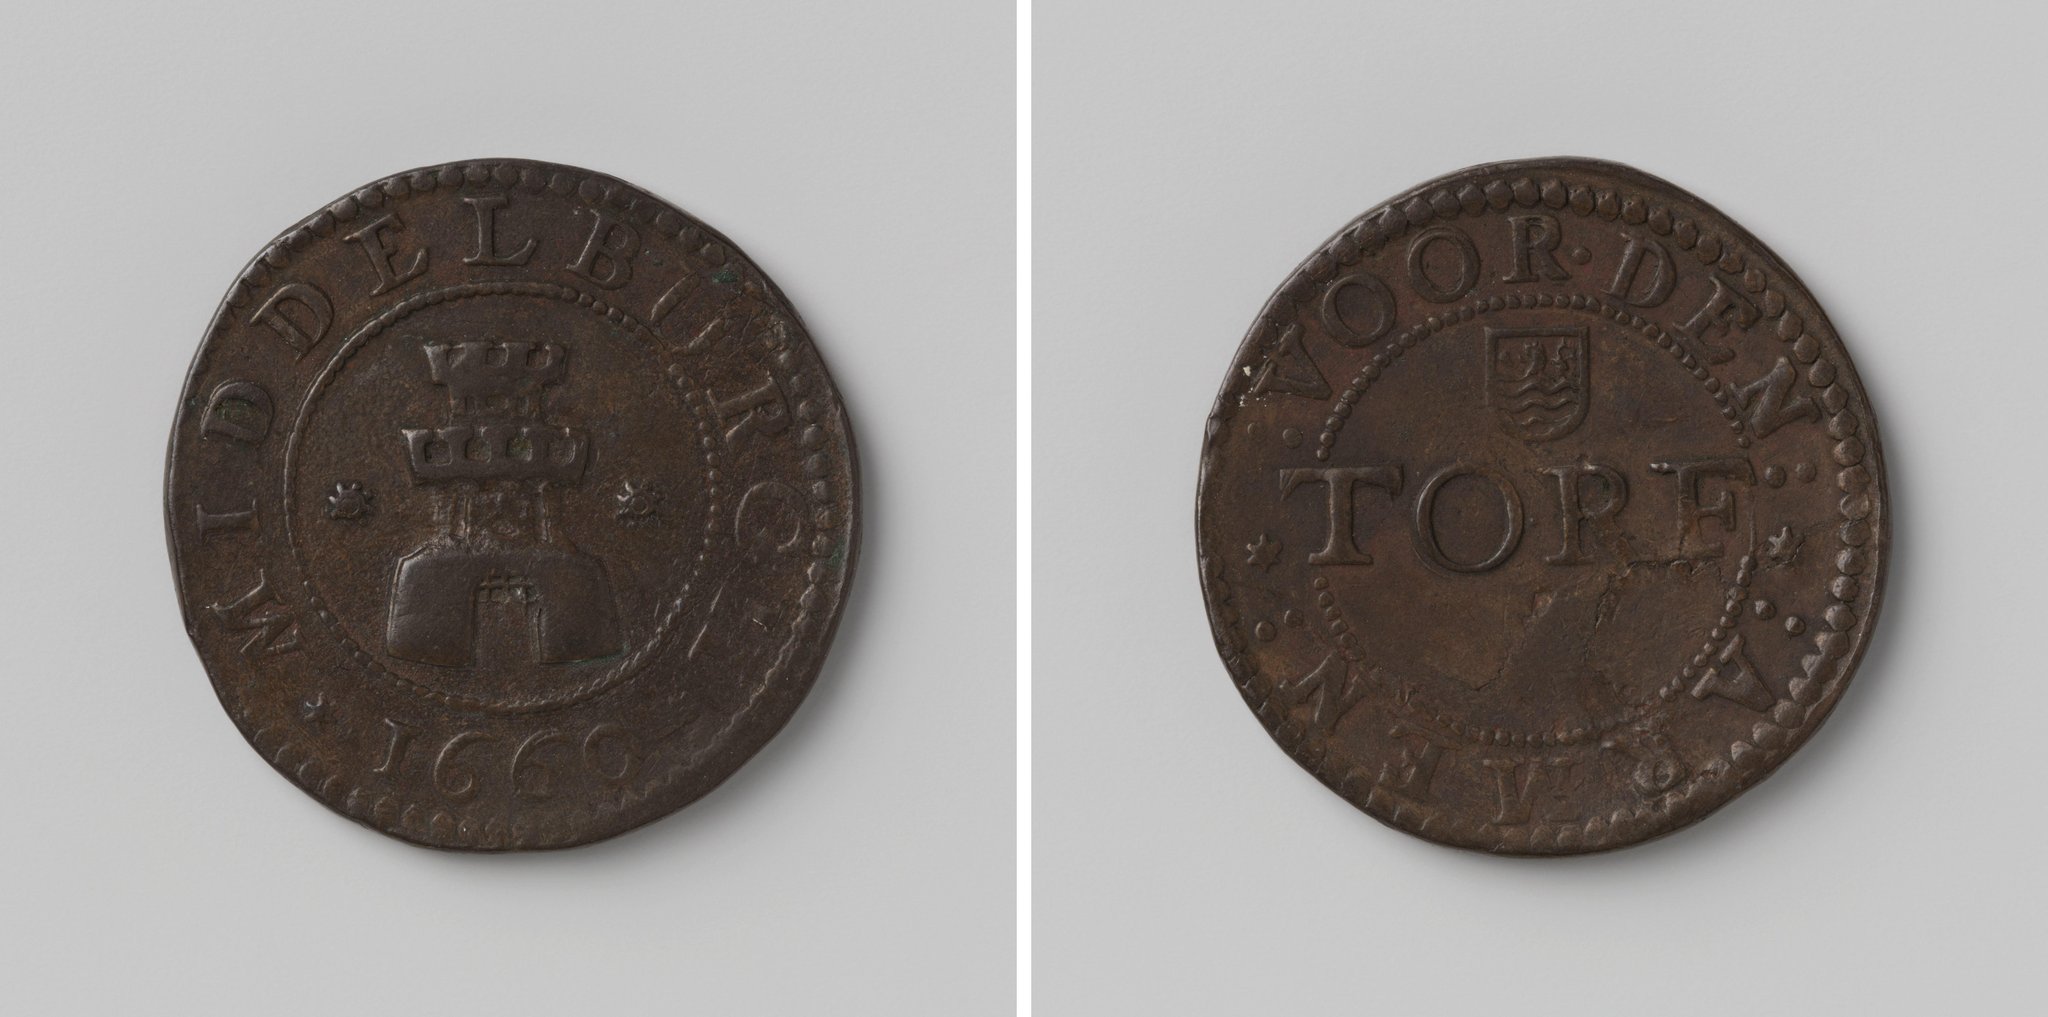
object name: armenloodje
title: Stad Middelburg, loodje dat bij uitdeling recht gaf op turf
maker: Anonymous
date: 1660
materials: copper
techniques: striking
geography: middelburg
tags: middelburg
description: Koperen penning. Voorzijde: burcht tussen twee sterretjes binnen omschrift en parelrand. Keerzijde: opschrift onder wapenschild binnen omschrift en parelrand